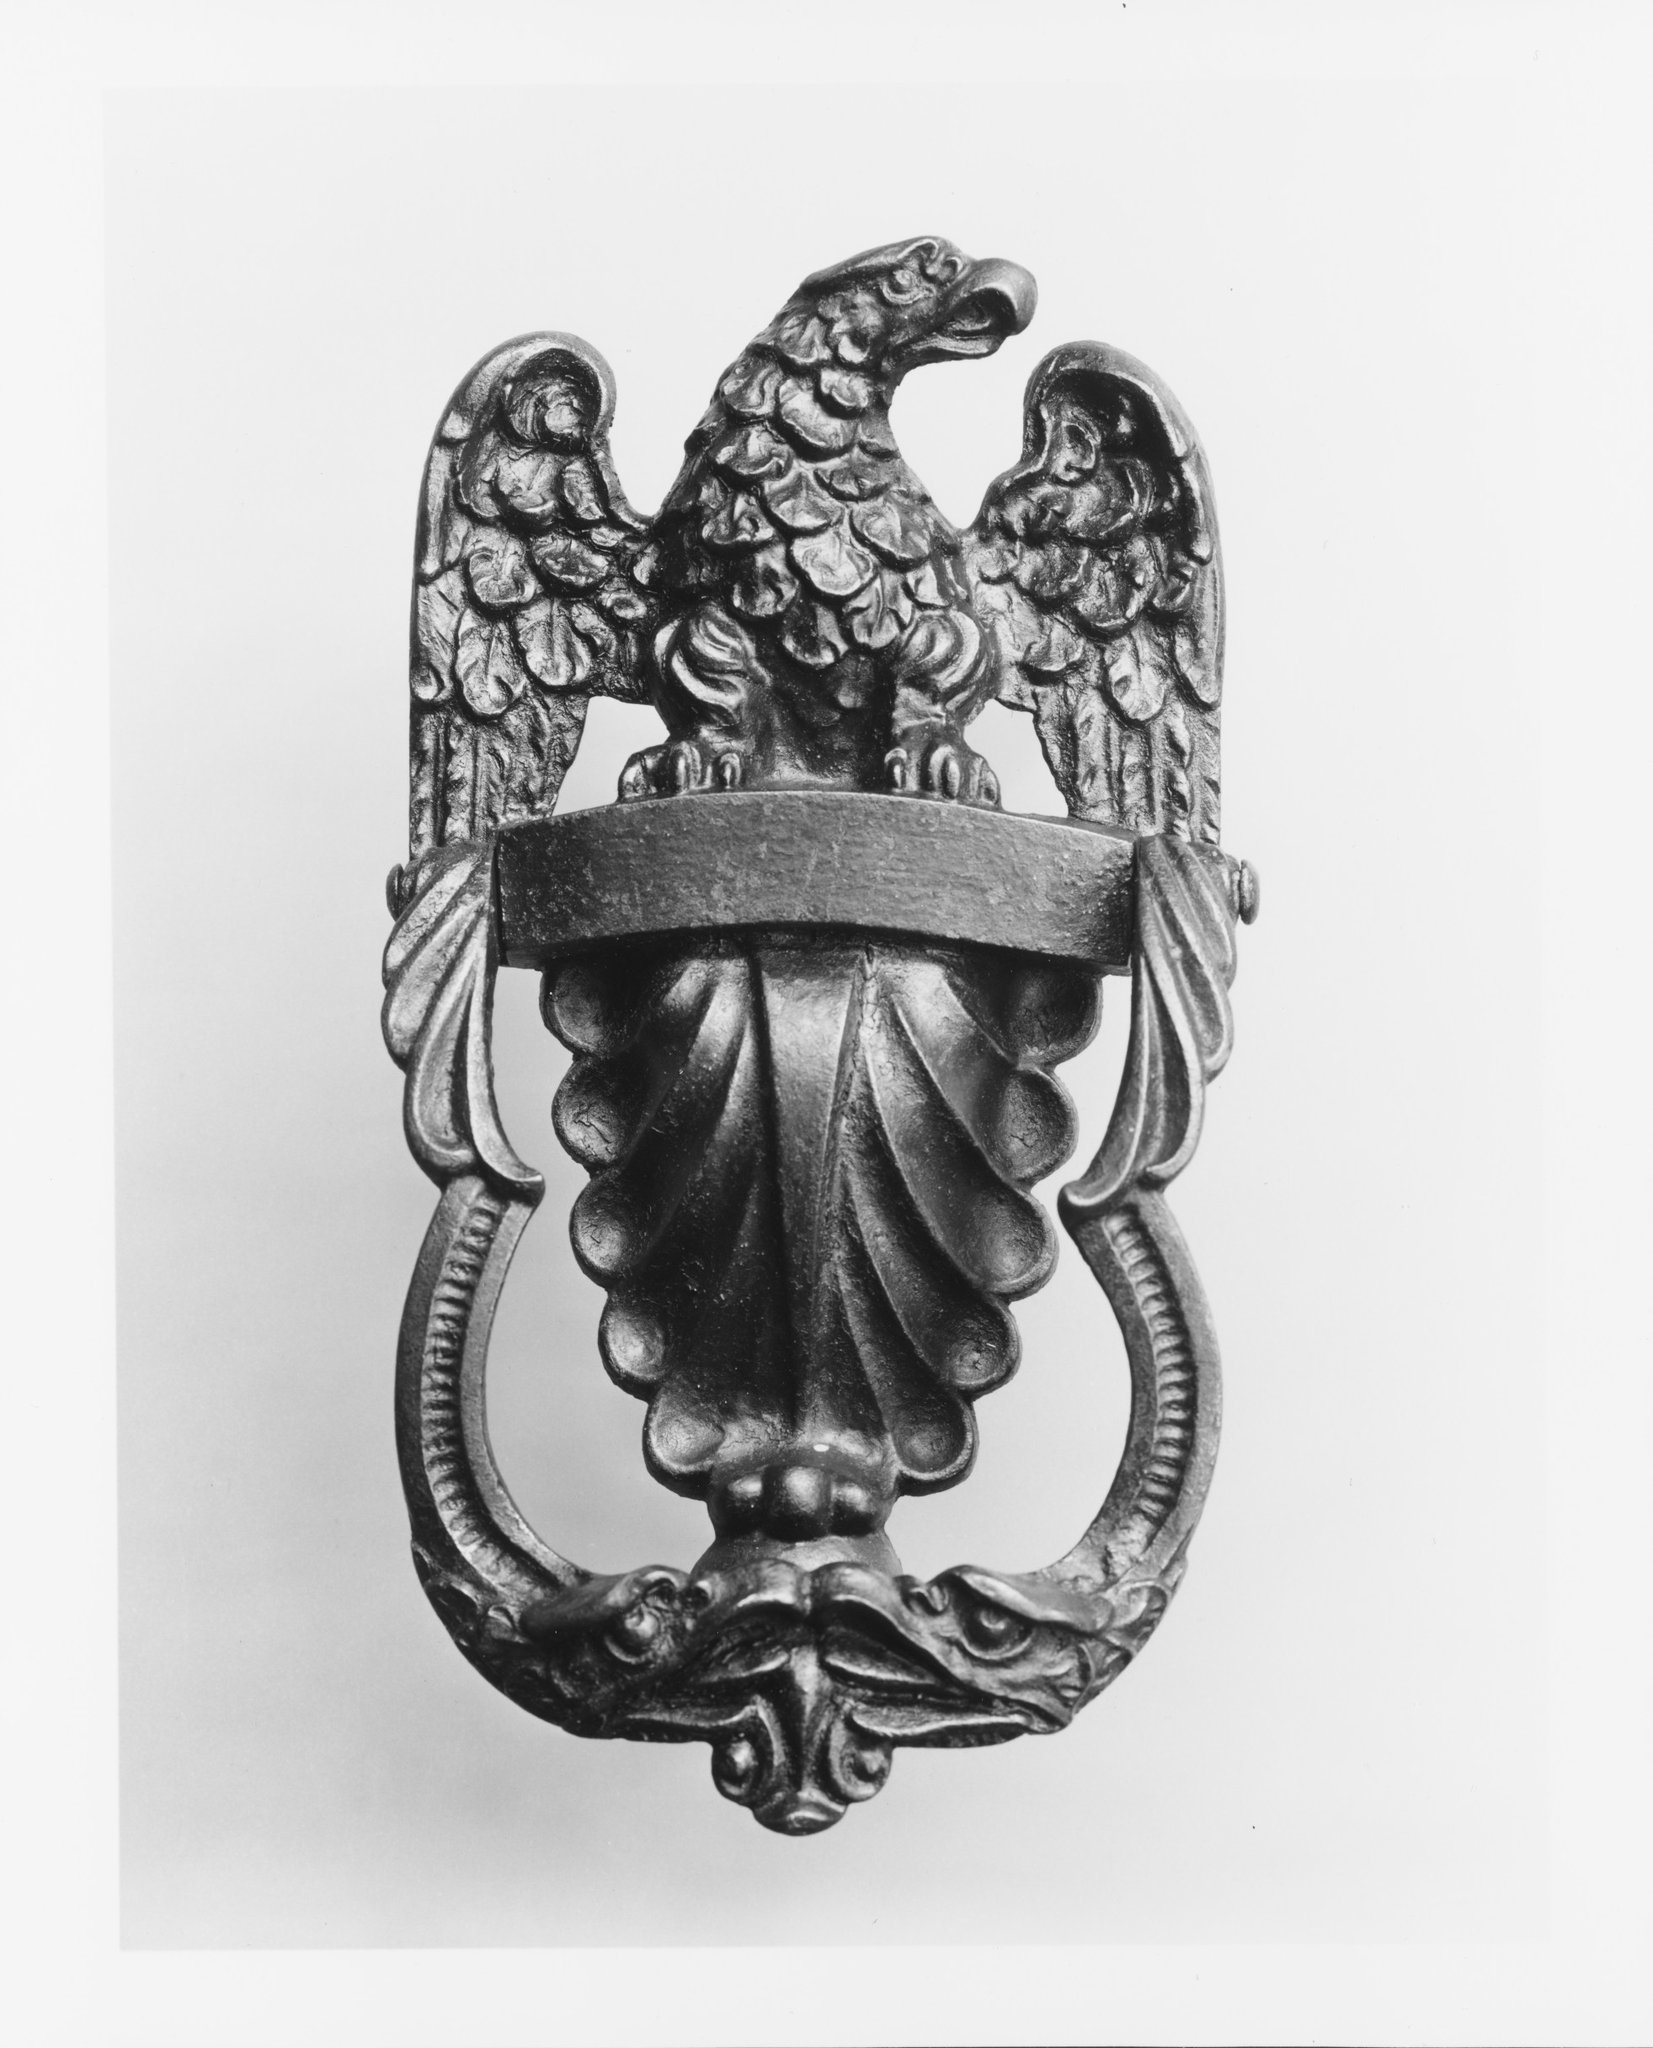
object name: knocker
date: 1800-1830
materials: iron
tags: eagles